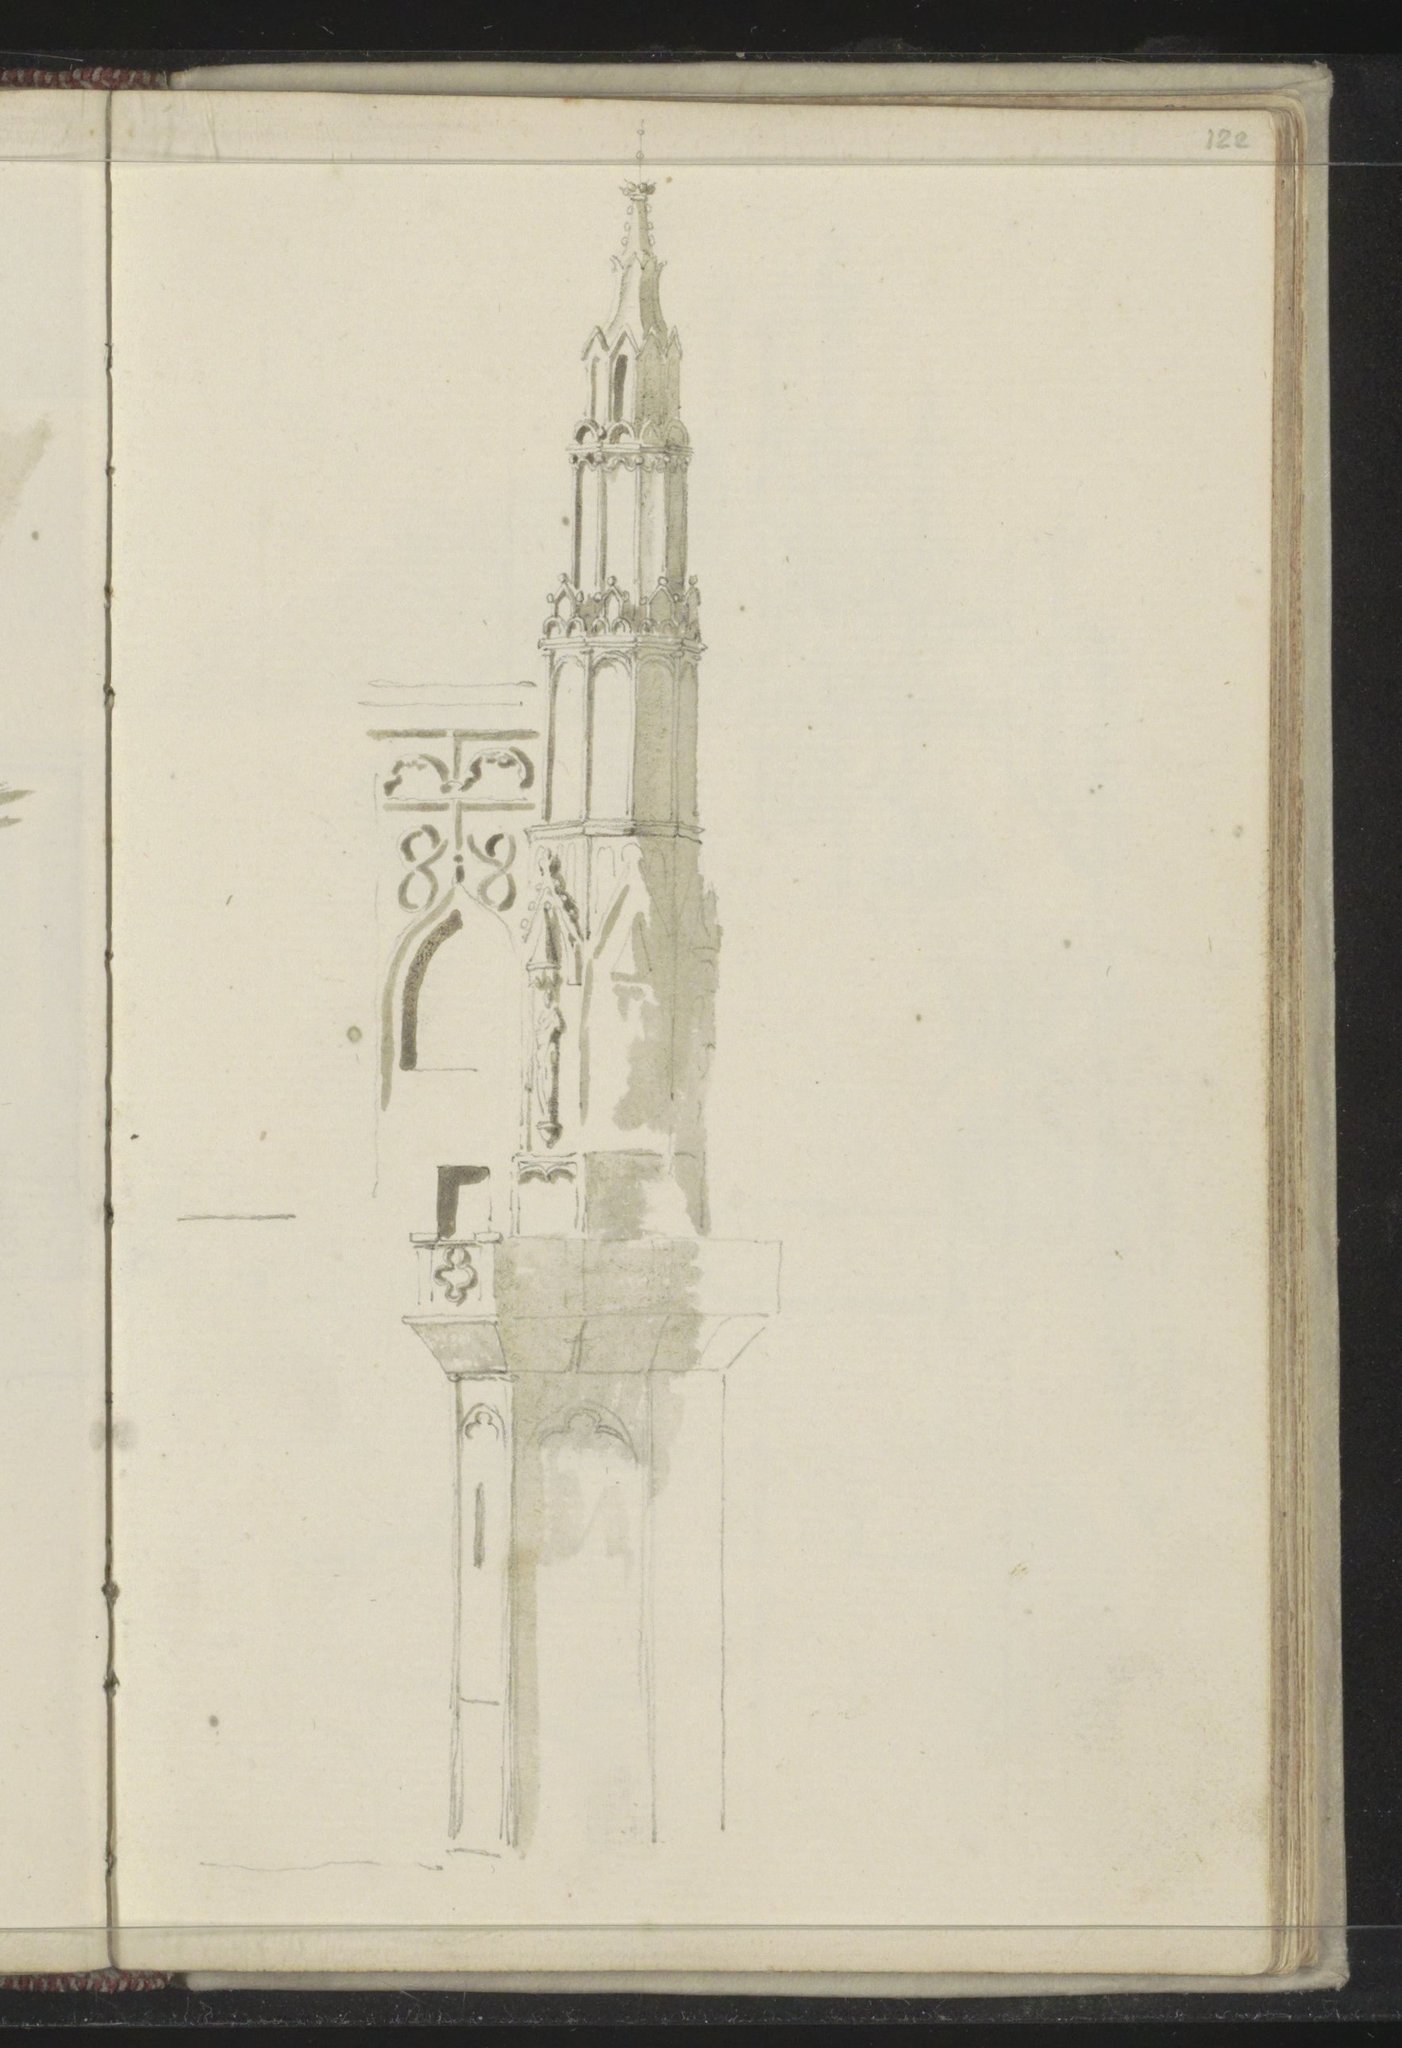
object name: sketchbook leaf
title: Gotische torenspits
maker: johannes huibert prins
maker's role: draughtsman, painter, print maker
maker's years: 1757-1806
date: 1783-1797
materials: paper, pencil, watercolor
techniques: brush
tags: parts of church exterior and annexes: spire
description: Pagina 122 uit een schetsboek met 175 pagina's.